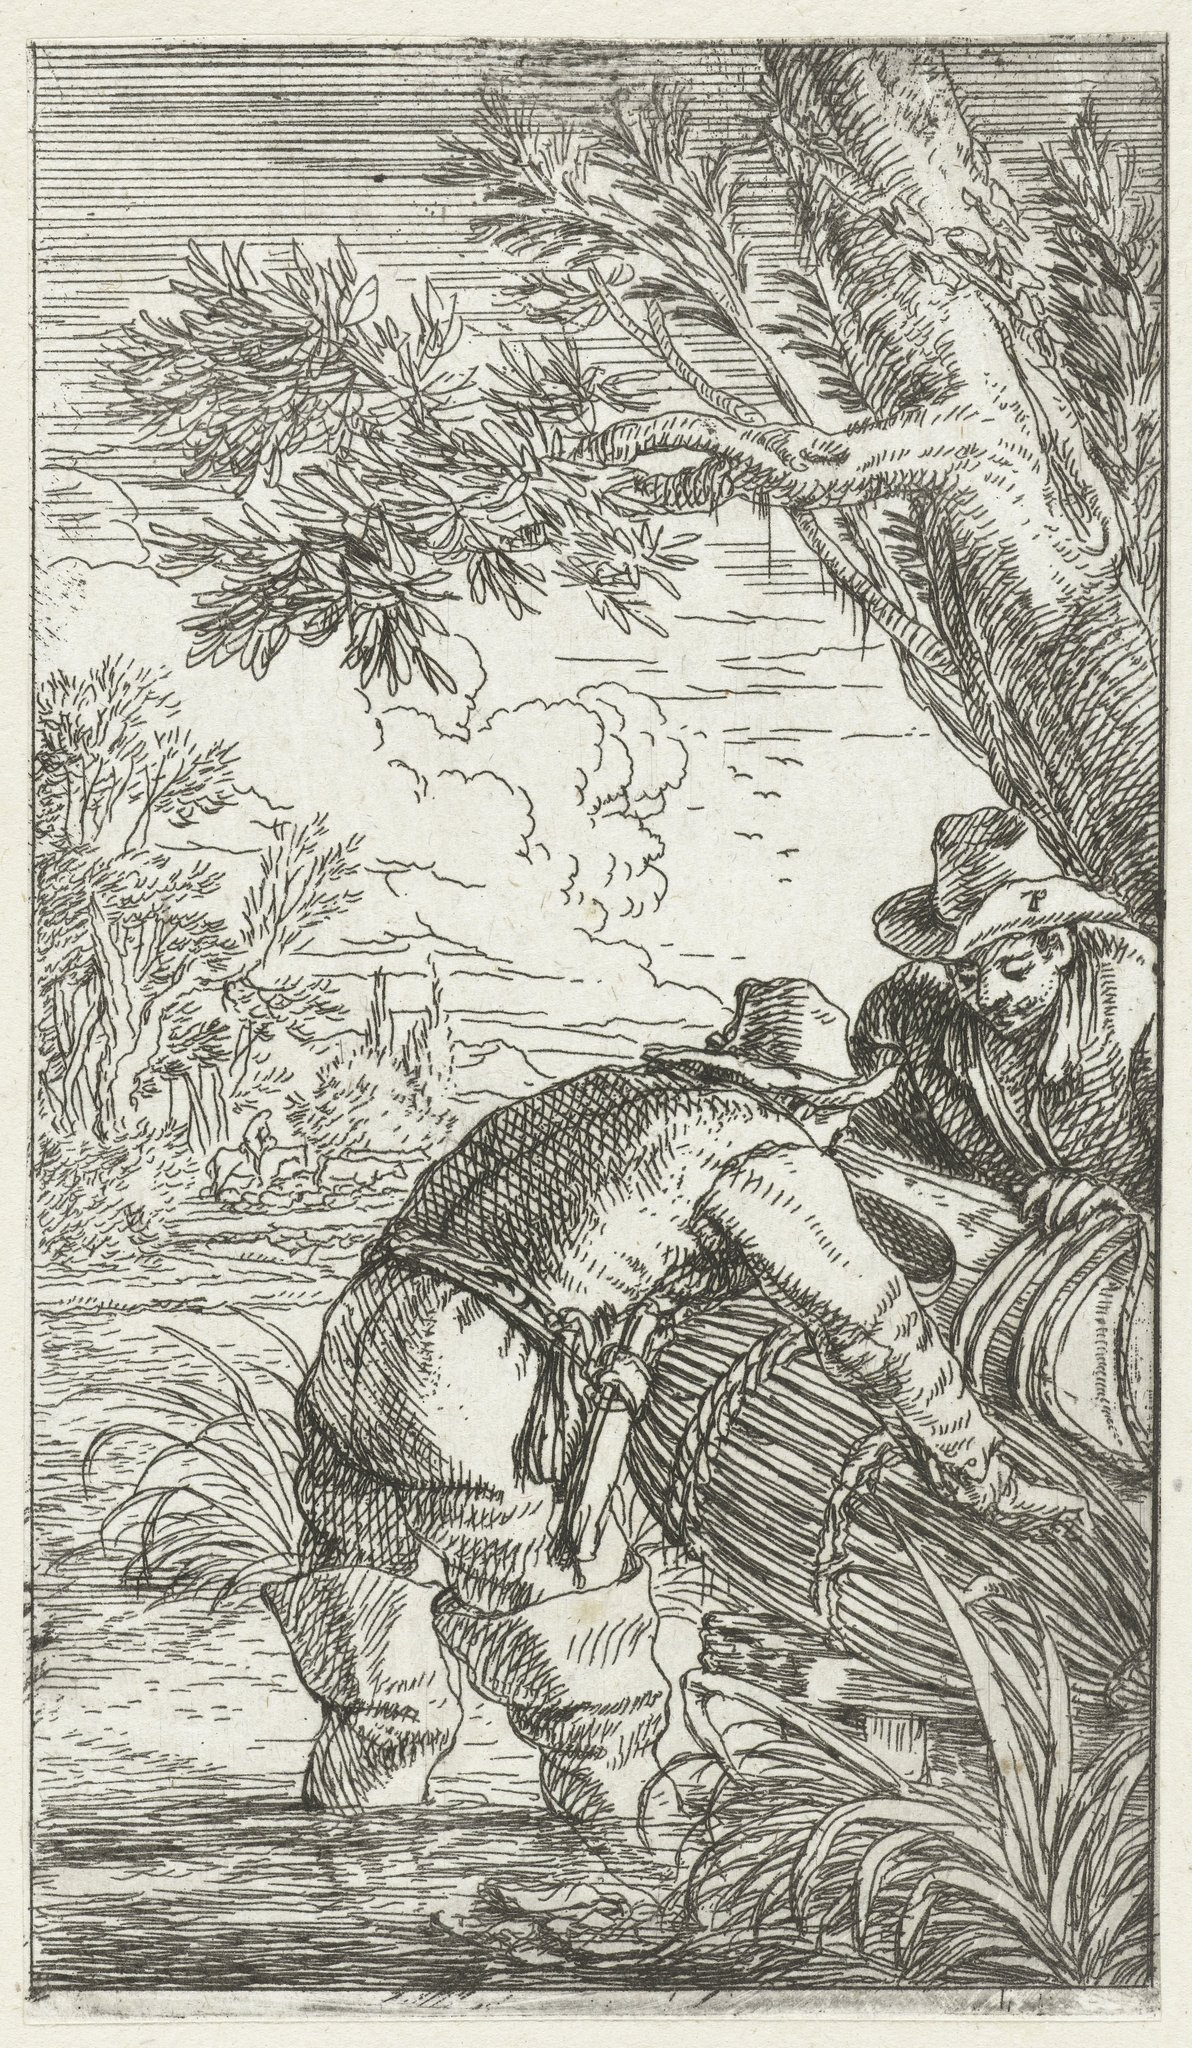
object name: print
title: Twee vissers met een fuik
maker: jonas umbach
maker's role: print maker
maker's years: 1624-1693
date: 1634-1693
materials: paper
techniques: etching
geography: augsburg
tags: sports, games ~ animals (+ live-basket), fisherman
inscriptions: collector's mark: Lugt 2228, collector's mark: Lugt 2760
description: Twee vissers staand in een rivier, de een met een fuik in zijn handen, de ander met de tas waar de vissen in meegenomen kunnen worden.